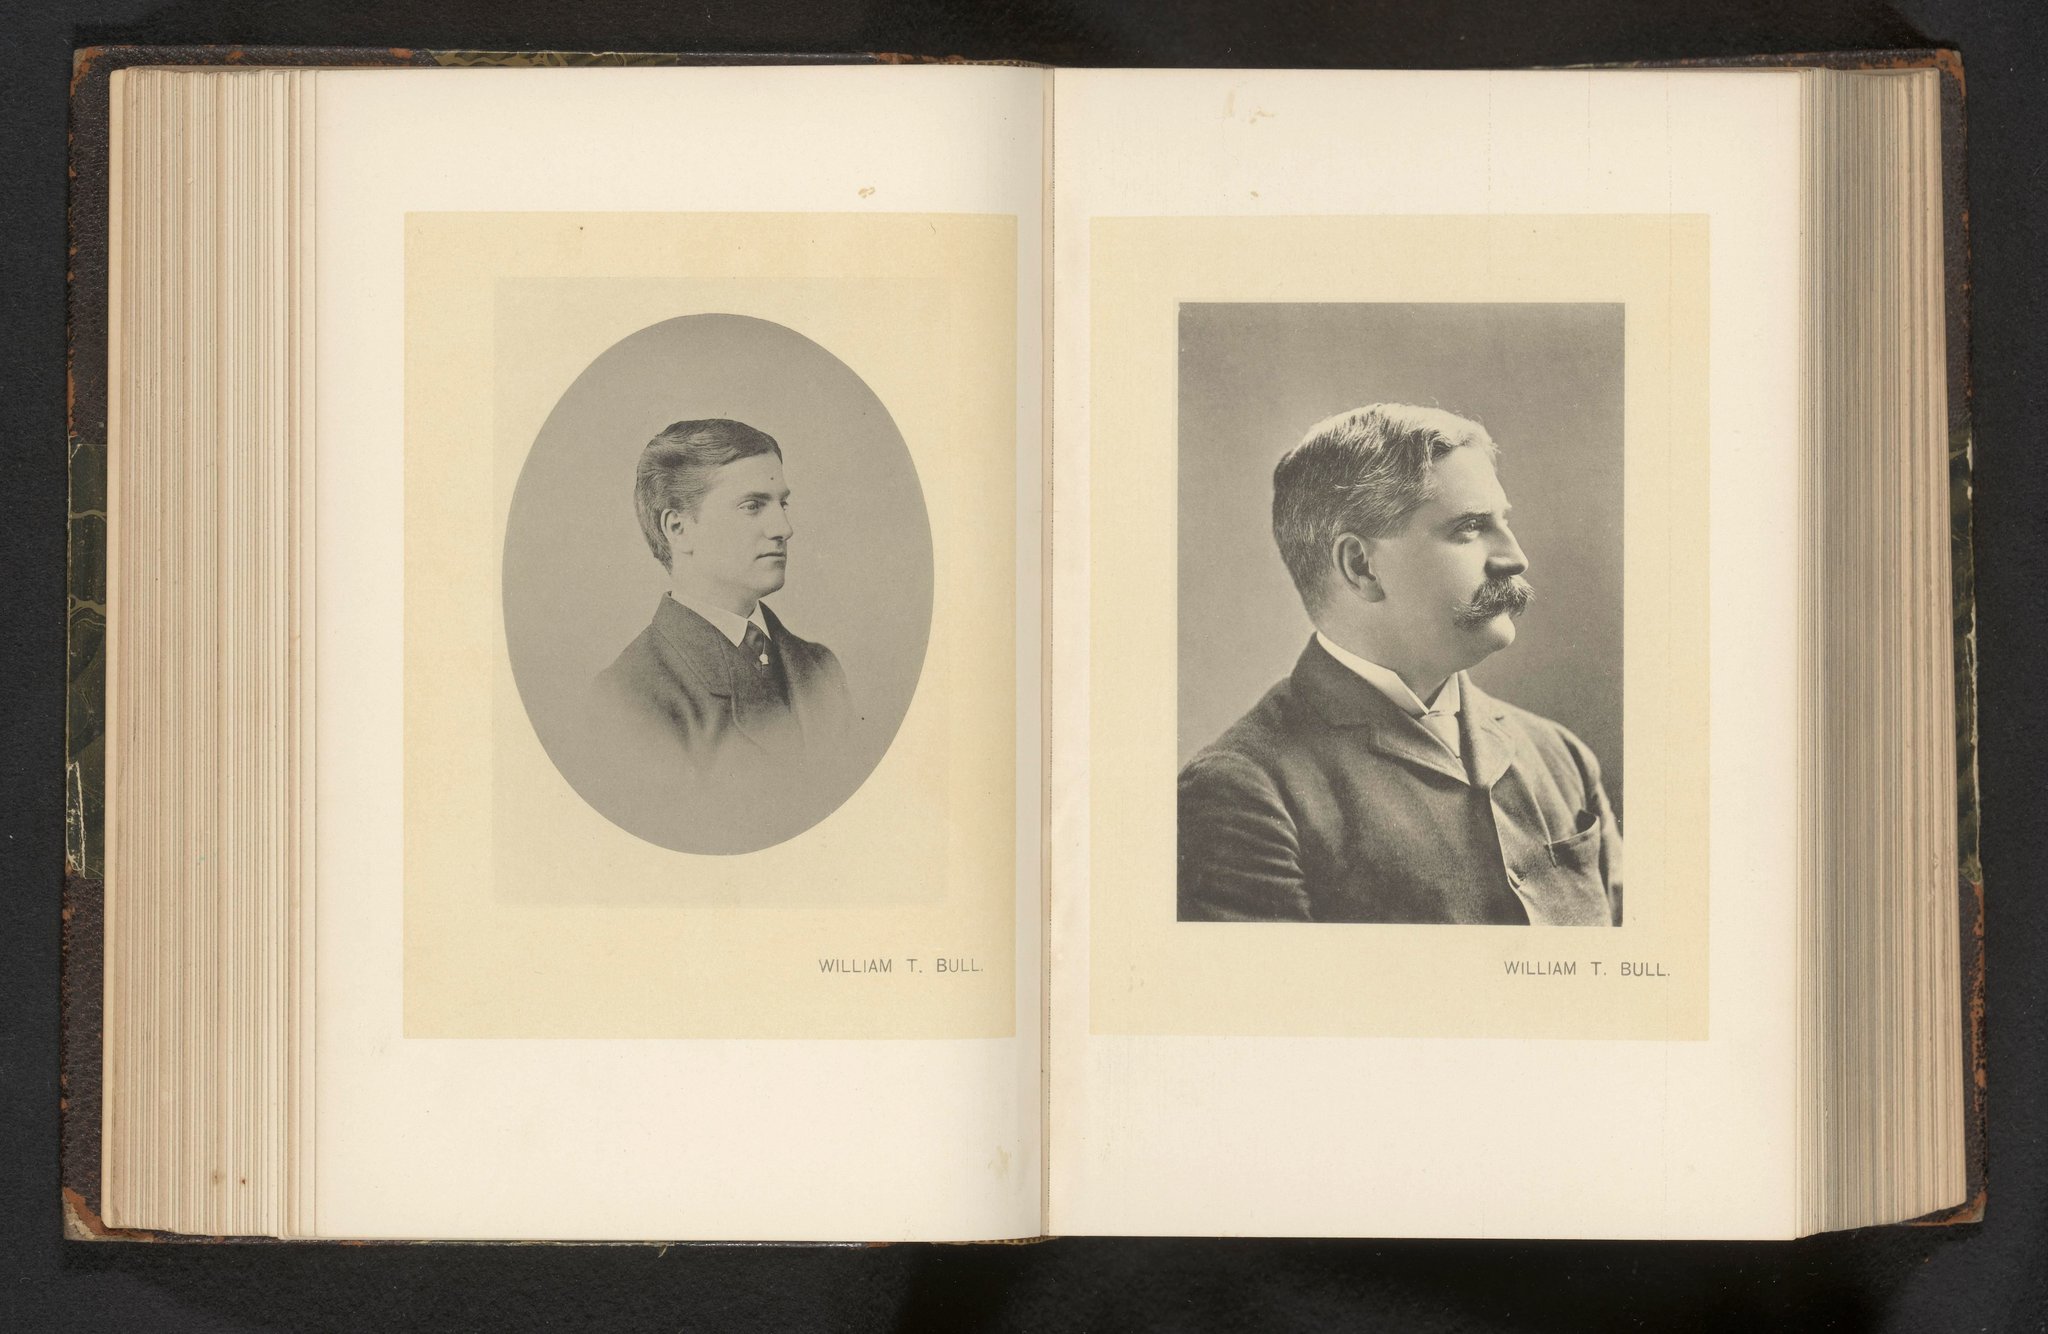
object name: page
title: William T. Bull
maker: Anonymous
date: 1869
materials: paper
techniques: photoaquatint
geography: boston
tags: adult man